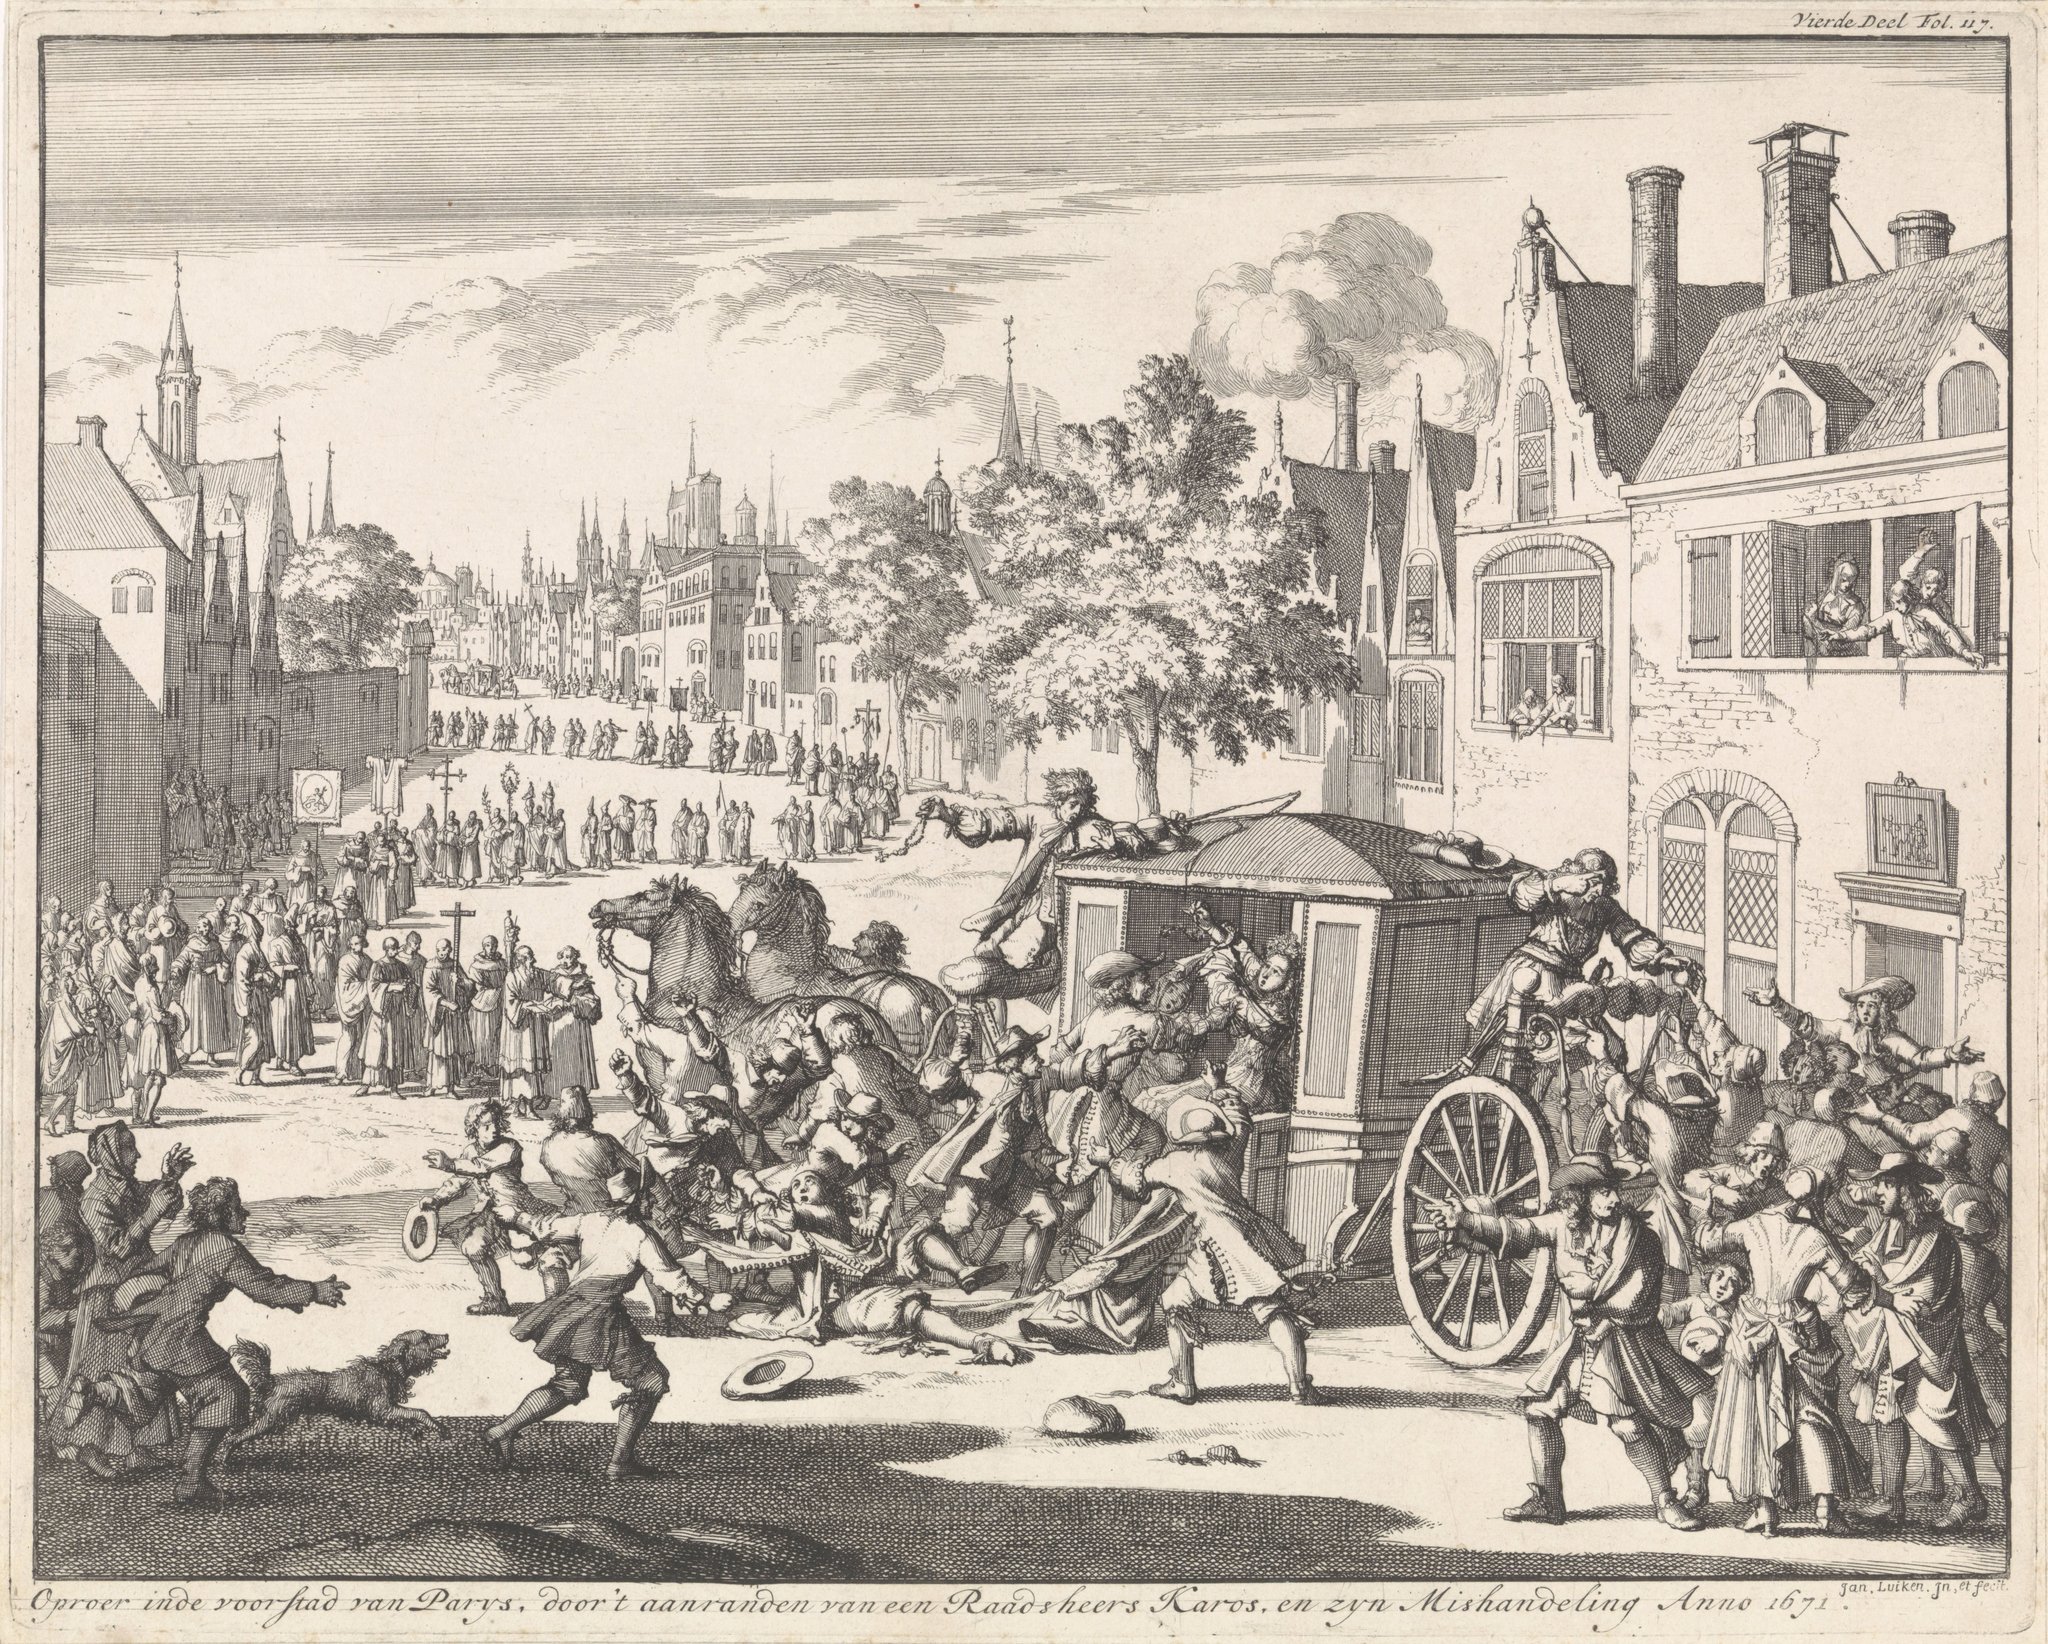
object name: book illustration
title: Oproer tijdens een processie in een voorstad van Parijs, 1671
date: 1696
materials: paper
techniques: etching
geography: amsterdam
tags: four-wheeled, animal-drawn vehicle, e.g.: cab, carriage, coach, procession ~ christian religion, violent death, being killed; being mishandled and maltreated; seeking death - ee - death not certain; wounded person, persecution of believers, paris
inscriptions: collector's mark: Lugt 2228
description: Illustratie uit: Benoist, Elie. Historie der gereformeerde kerken van Vrankryk, 4 delen. Amsterdam: Jan Claesz ten Hoorn, 1696, dl. IV.